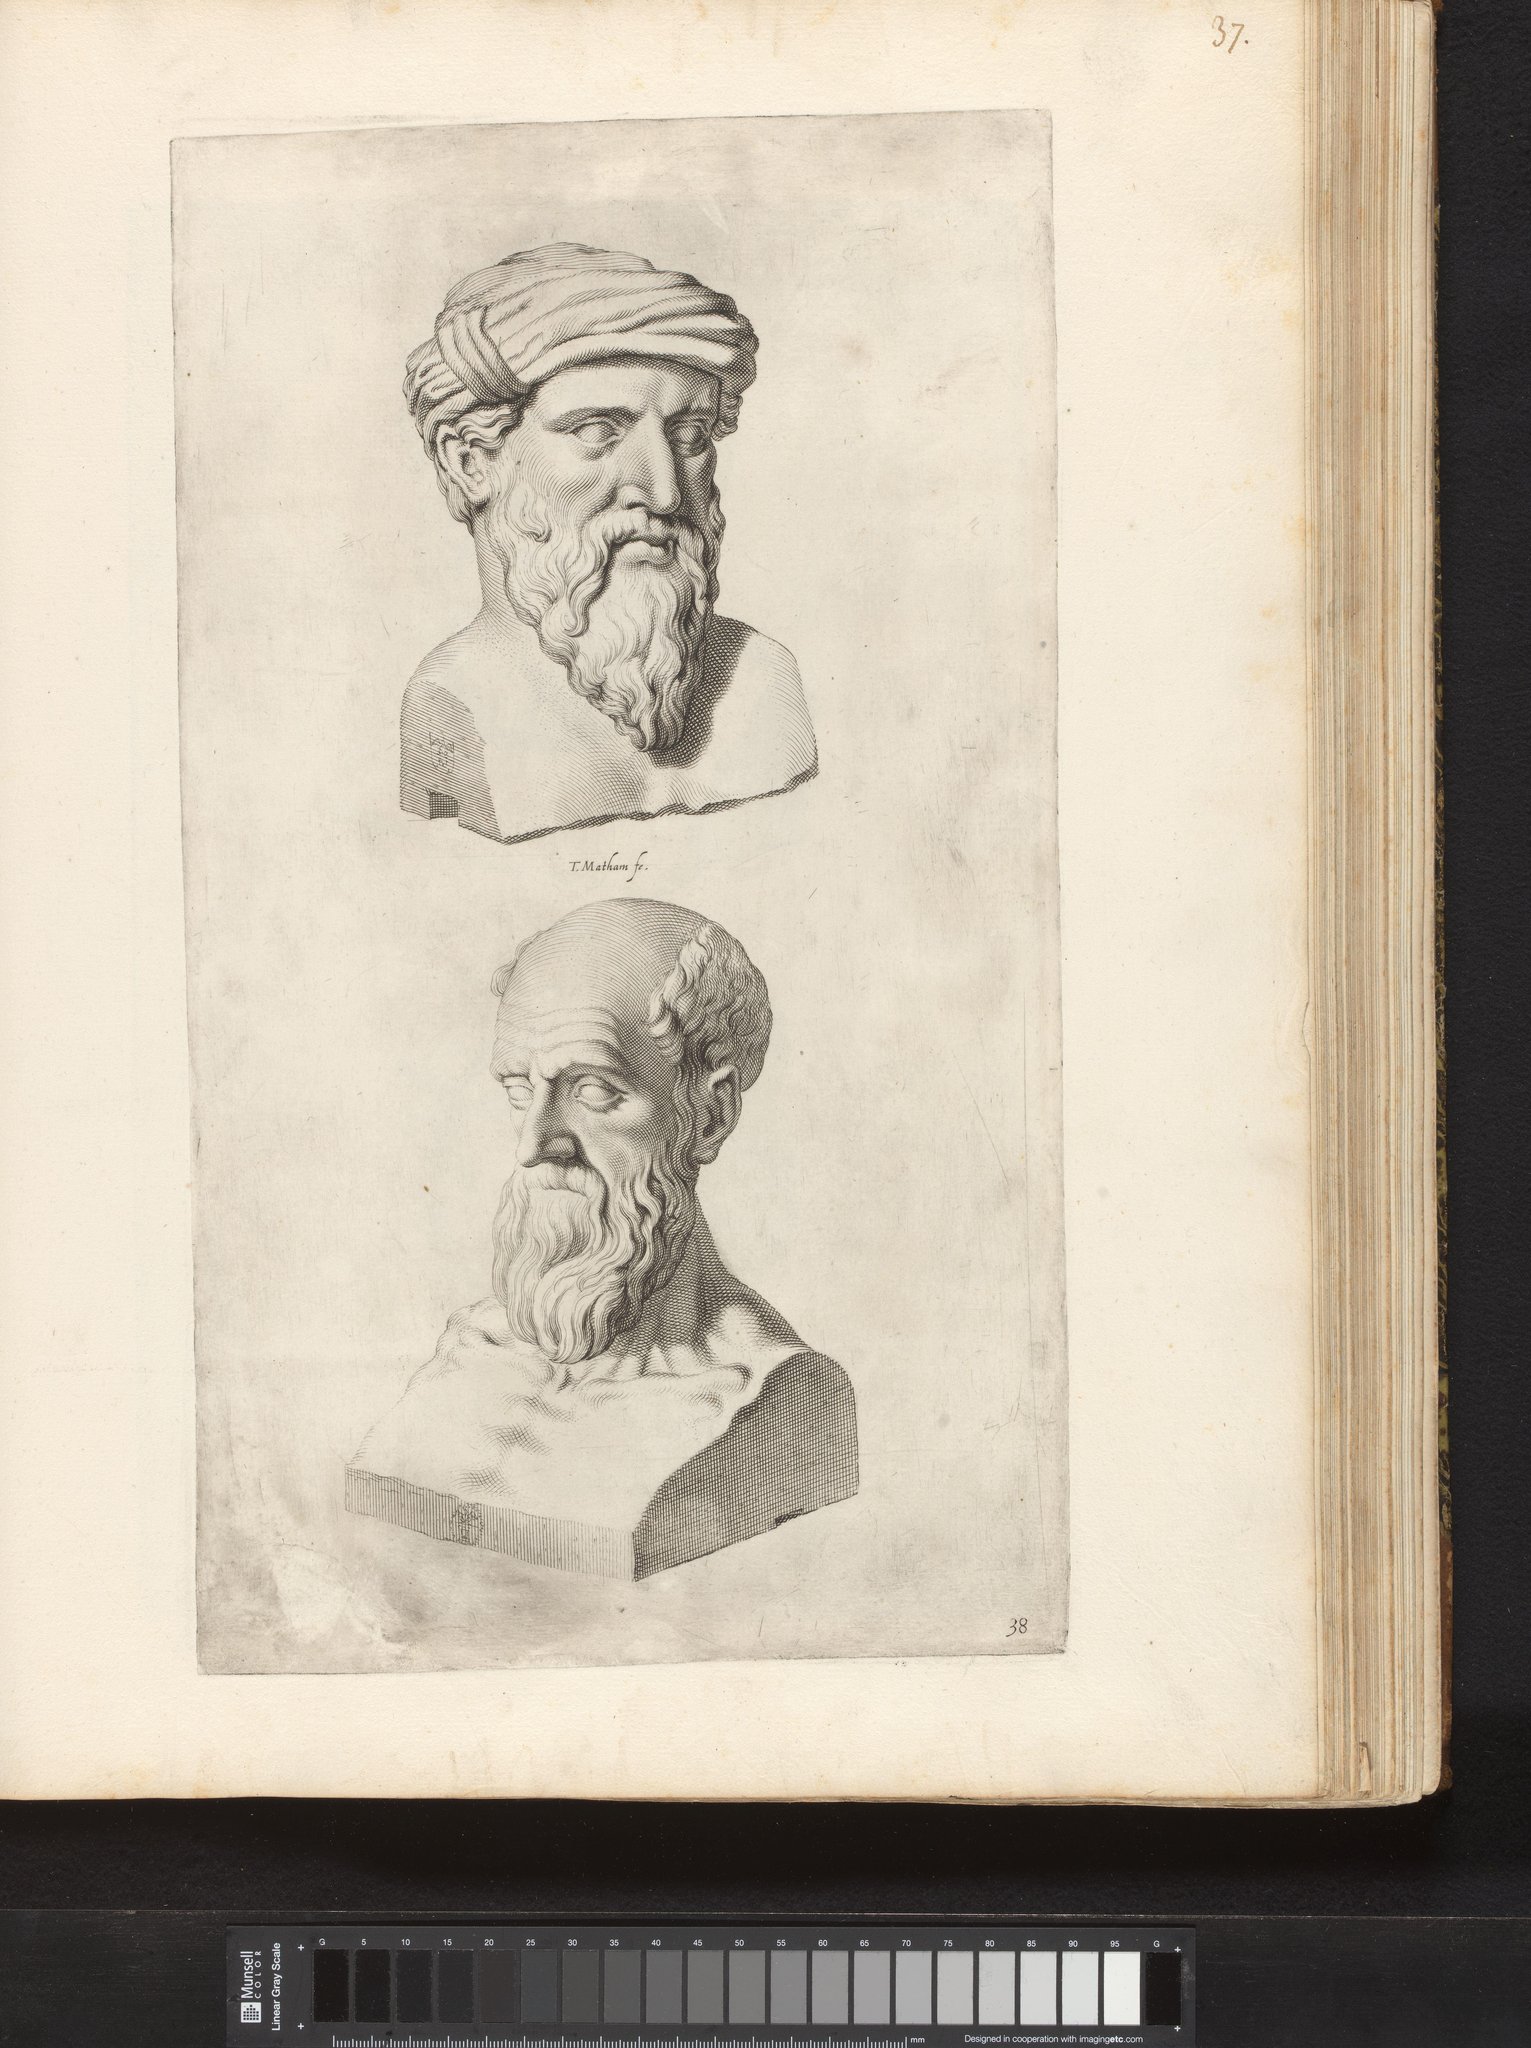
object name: album leaf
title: Bustes van Apollo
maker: michel natalis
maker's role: print maker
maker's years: 1610-1668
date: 1636-1647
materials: paper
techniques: engraving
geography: rome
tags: (story of) apollo (phoebus), piece of sculpture, reproduction of a piece of sculpture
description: Twee antieke bustes van Apollo. Op de bustes het wapenschild van Vincenzo Giustiniani. Prent maakt deel uit van een album met een serie prenten naar de sculpturen in de verzameling in de Galleria Giustiniani te Rome.